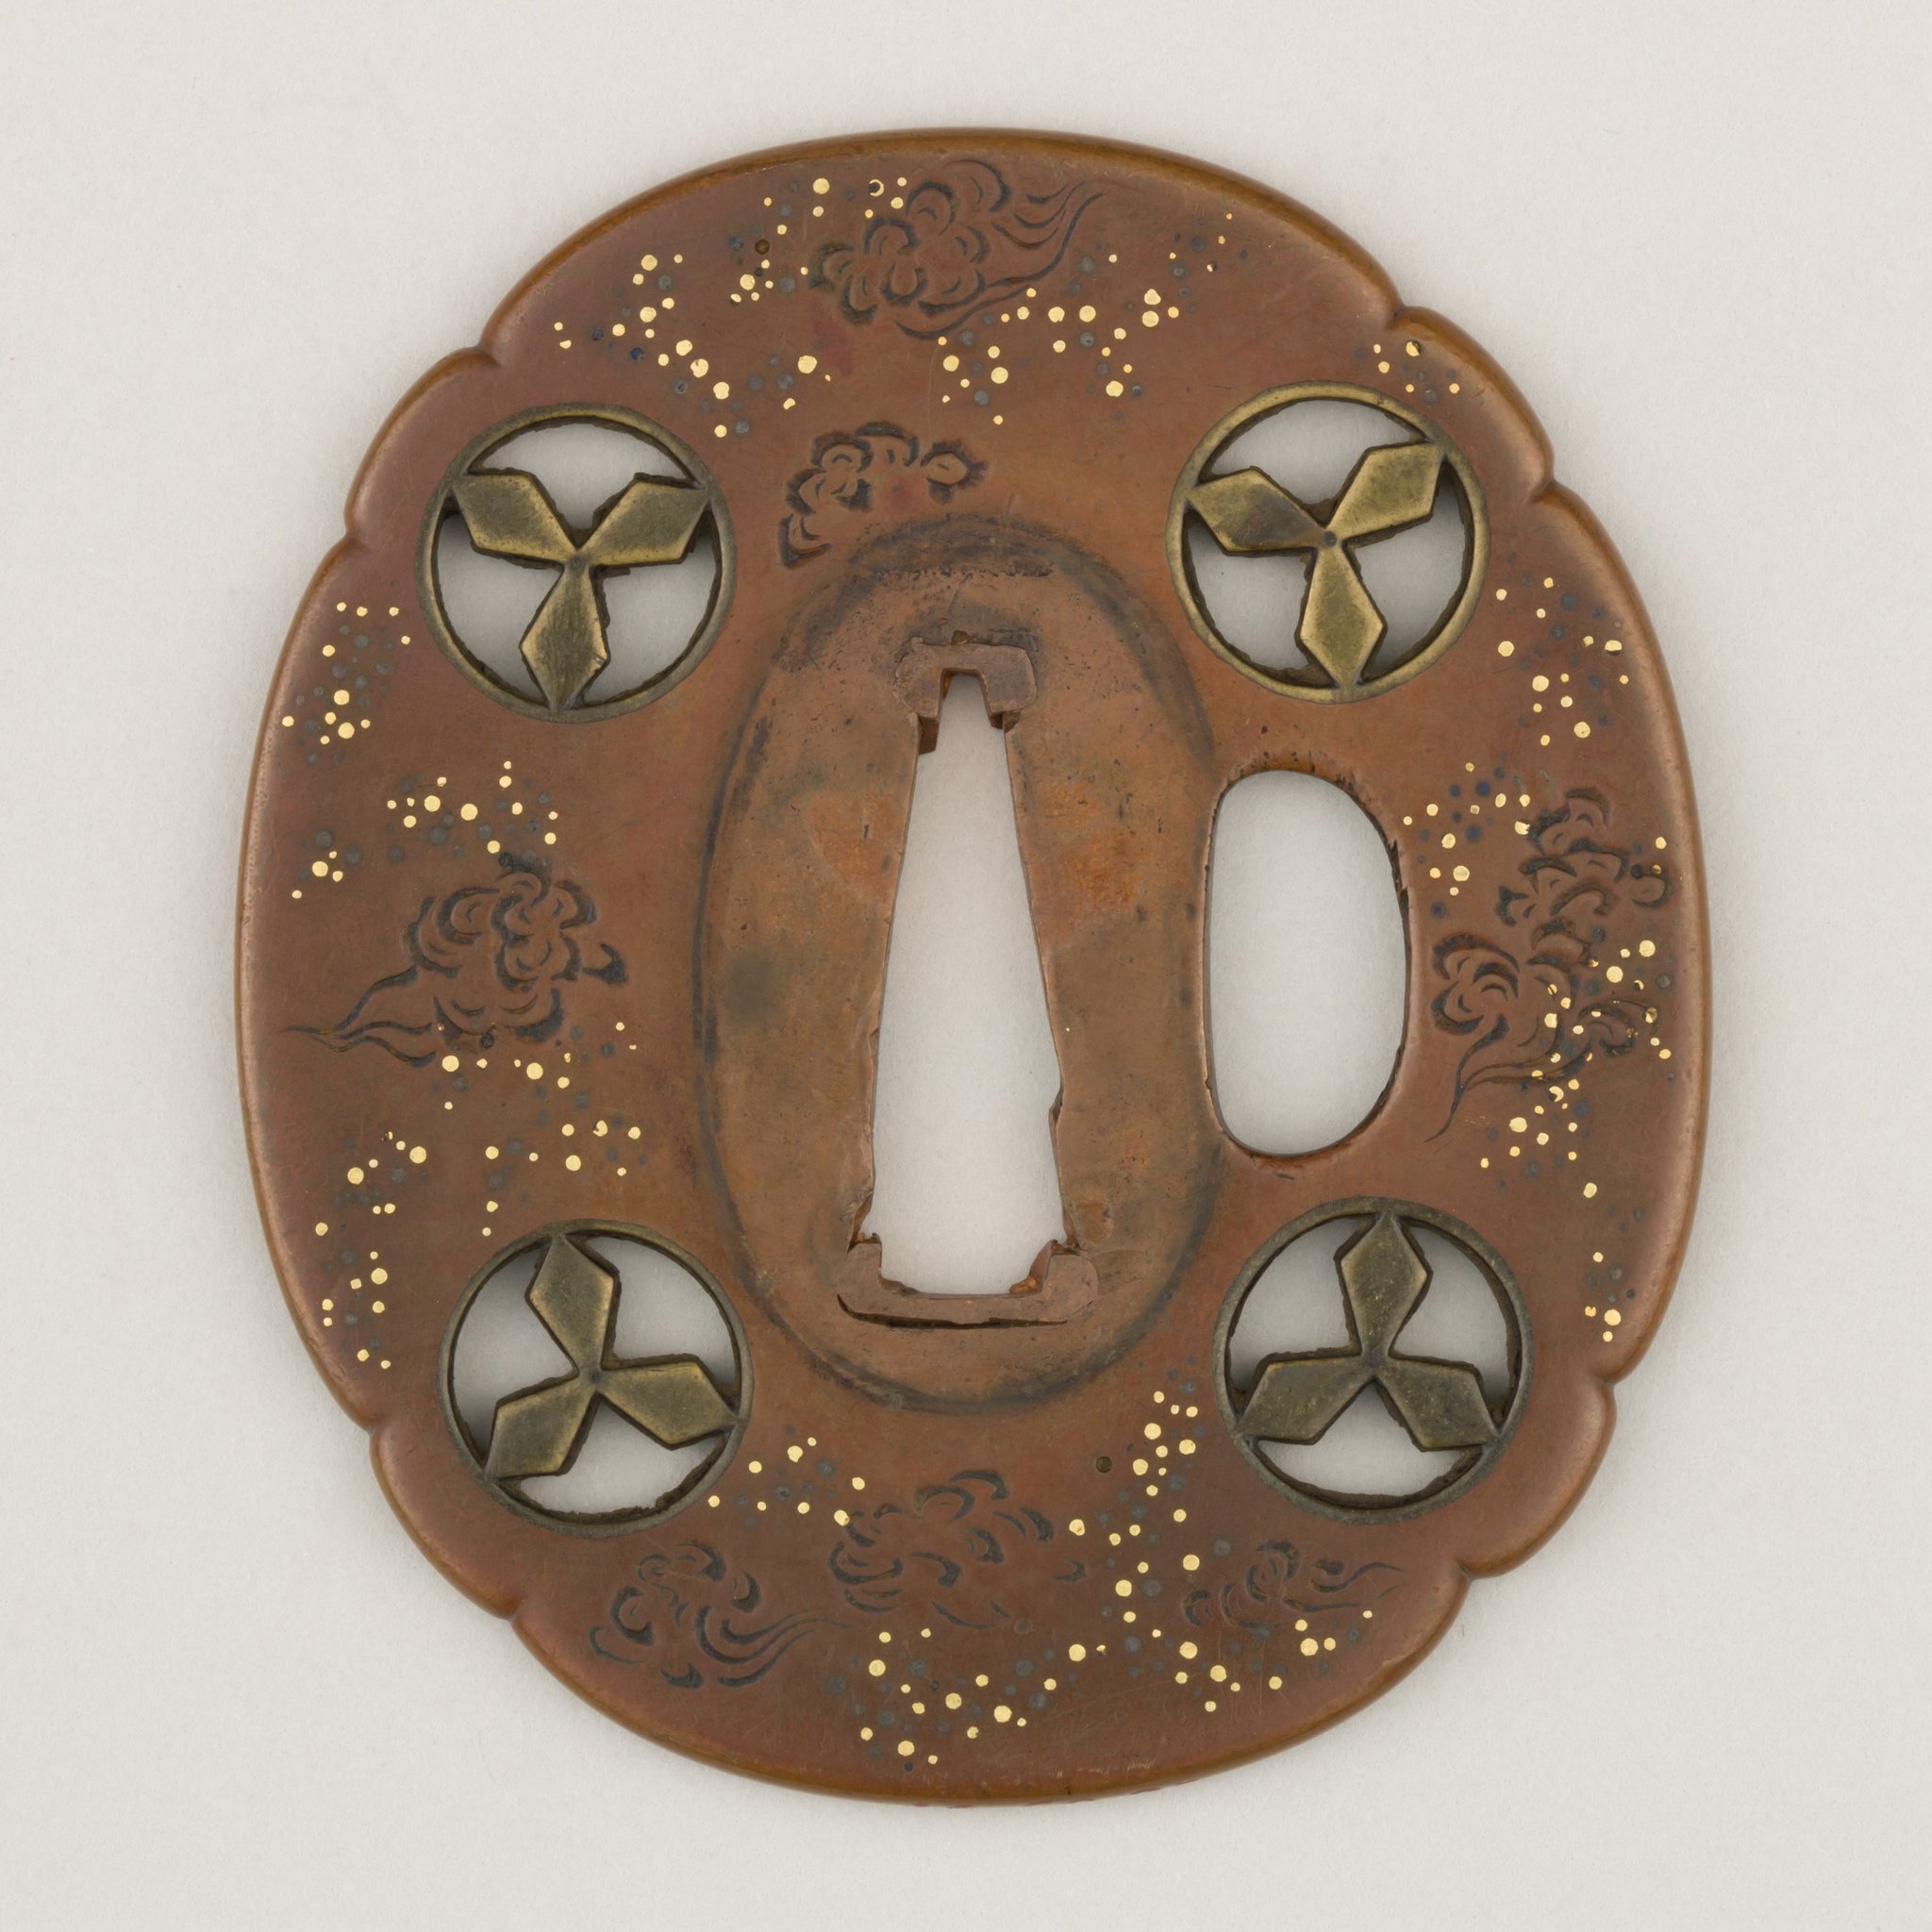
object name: sword guard tsuba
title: Sword Guard (Tsuba)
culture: japanese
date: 1601-1700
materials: copper, gold alloy, gold, silver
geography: japan